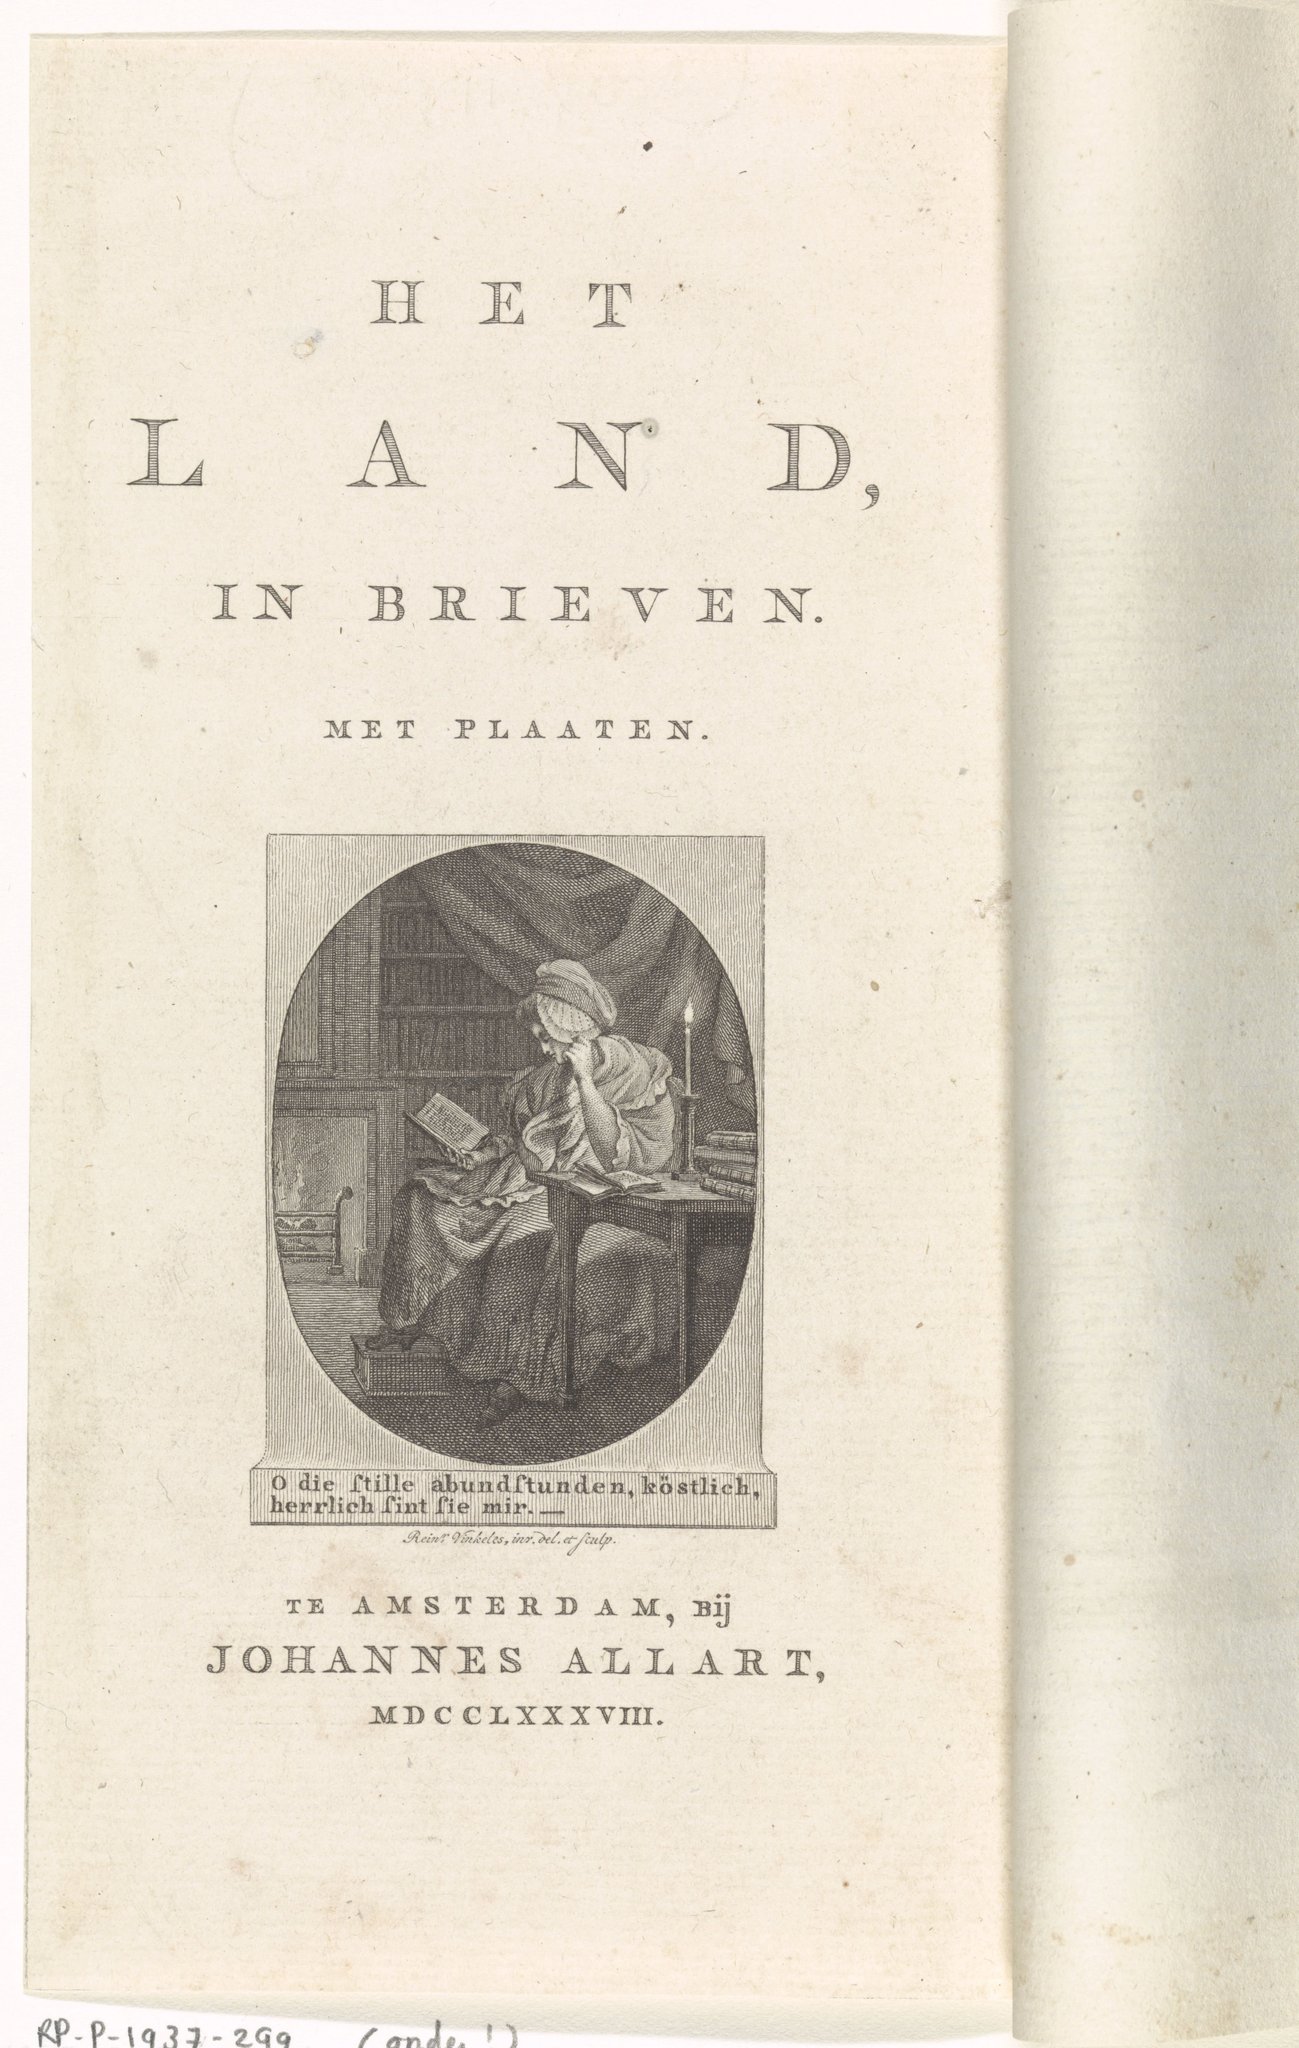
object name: titelblad, titelpagina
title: Titelpagina voor: A.M. Post, Het Land in brieven, 1788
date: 1788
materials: paper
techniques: engraving, etching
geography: amsterdam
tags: reading, candle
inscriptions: collector's mark: Lugt 2228, collector's mark: Lugt 2760